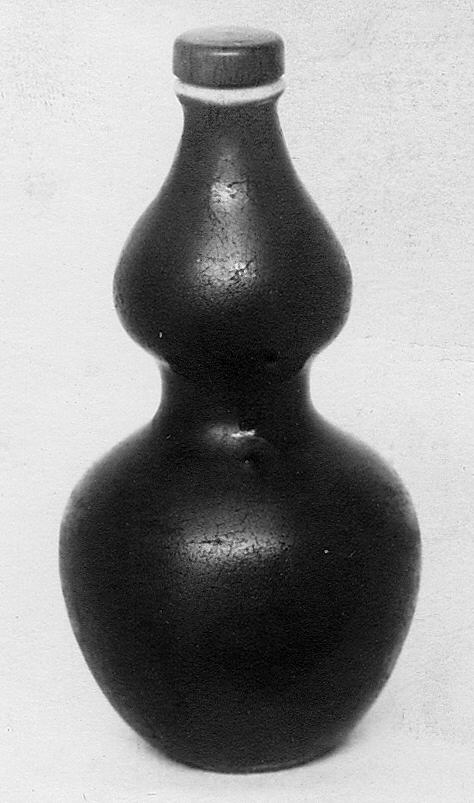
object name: snuff bottle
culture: chinese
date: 1662-1722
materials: porcelain